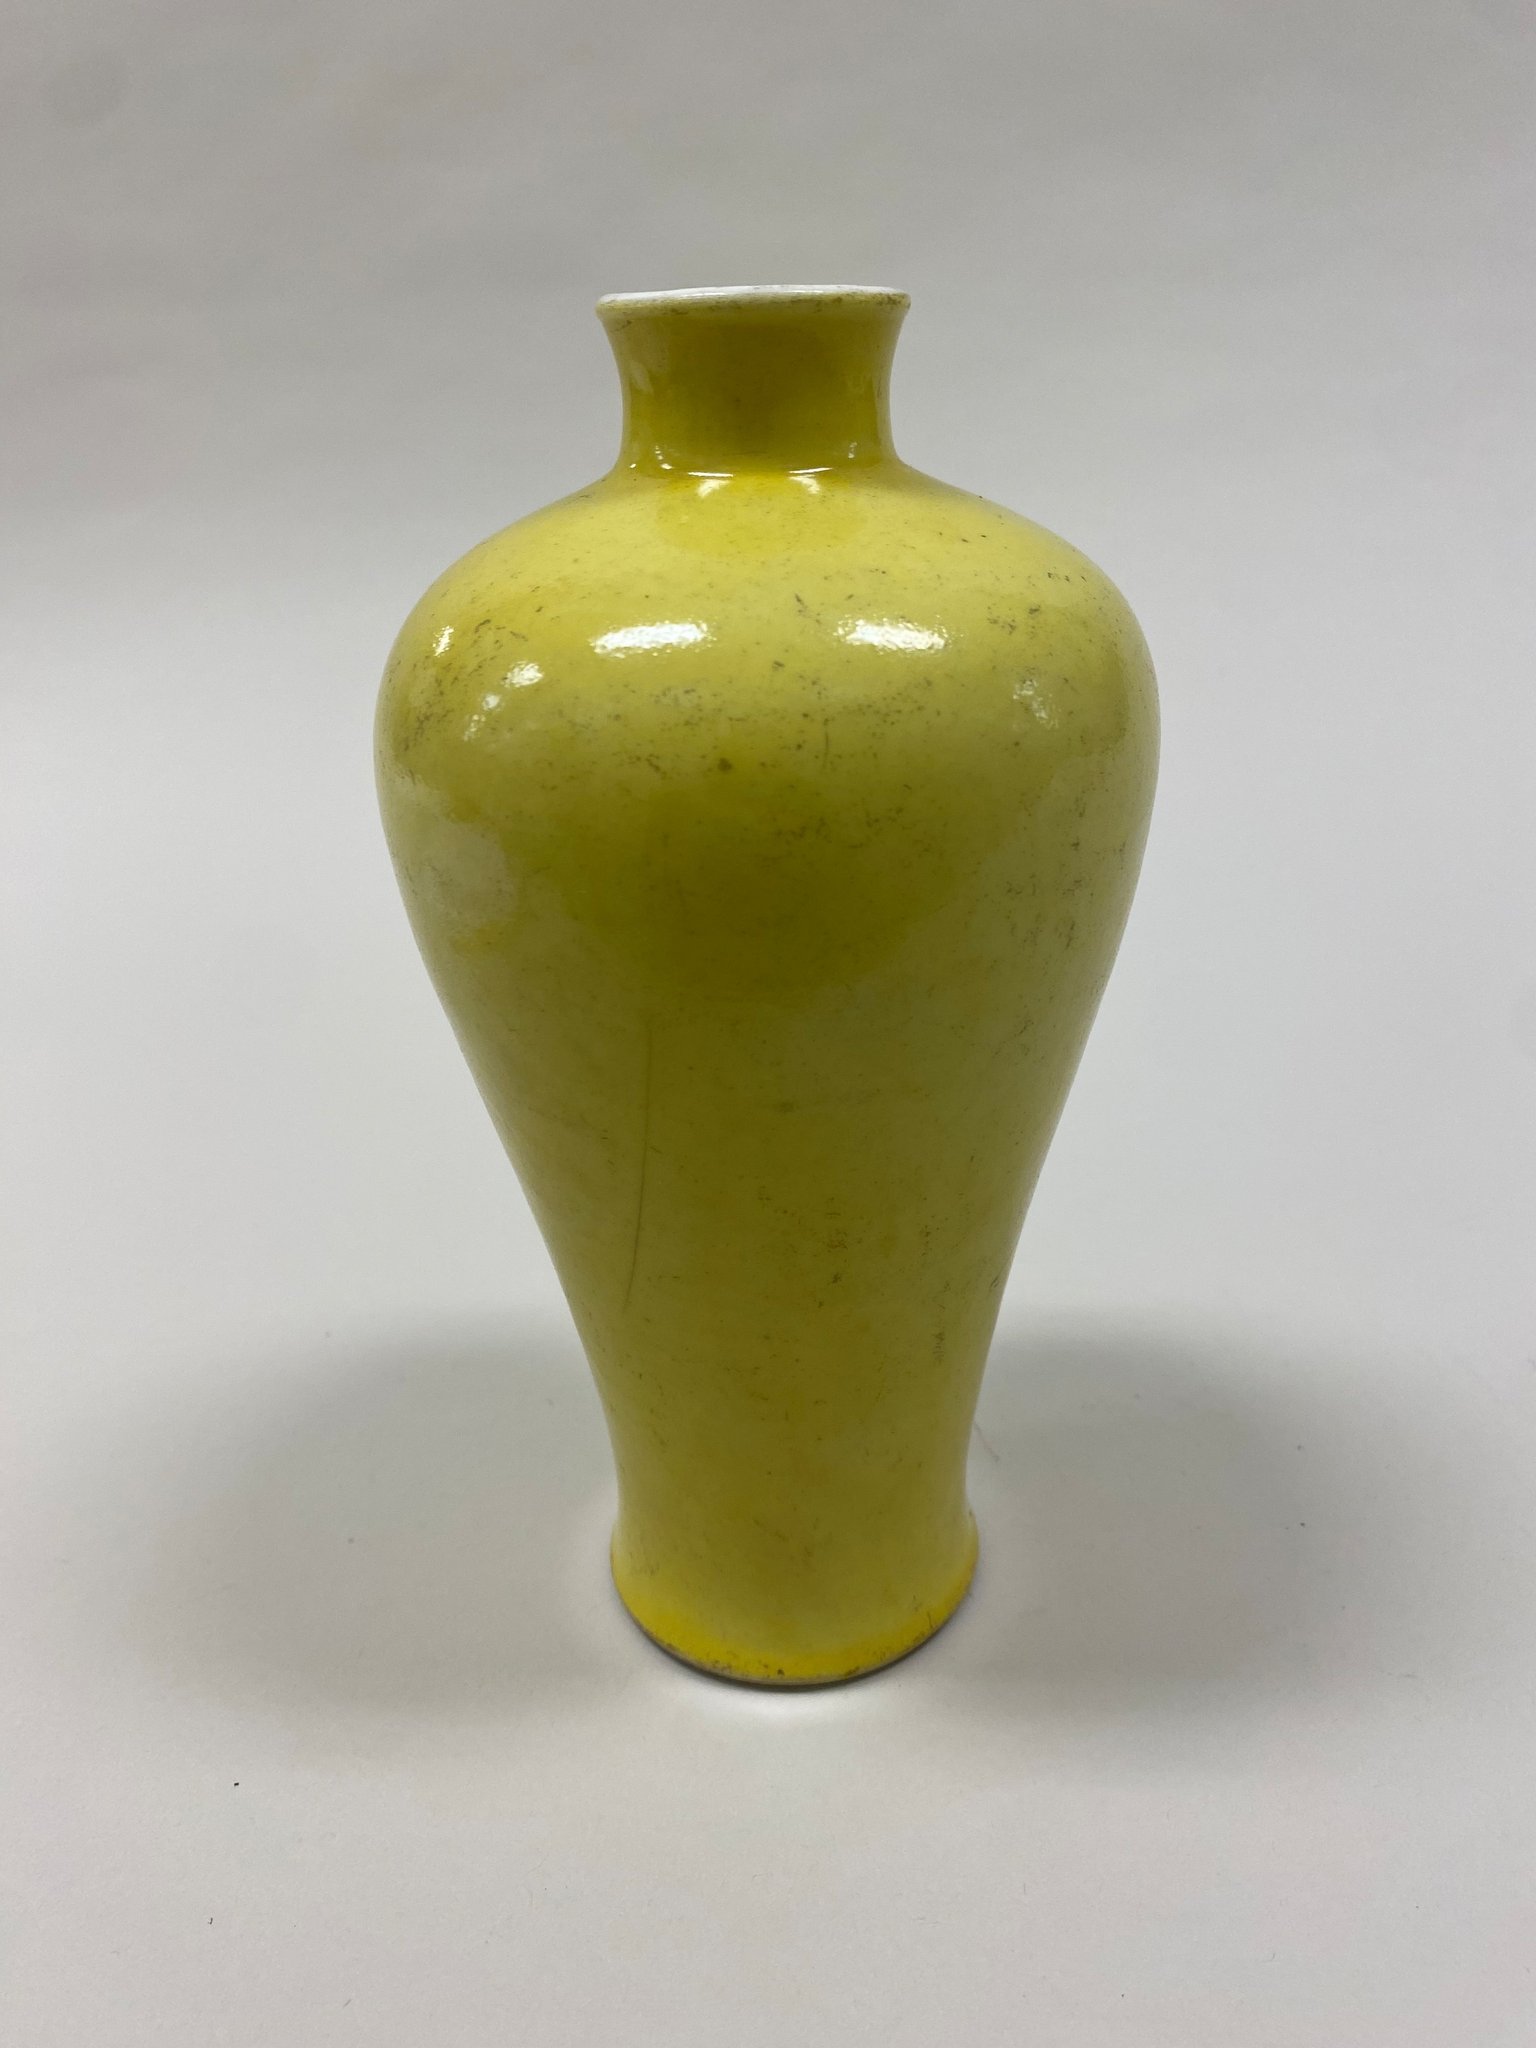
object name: vase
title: Meiping vase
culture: chinese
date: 1701-1800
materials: glaze, porcelain